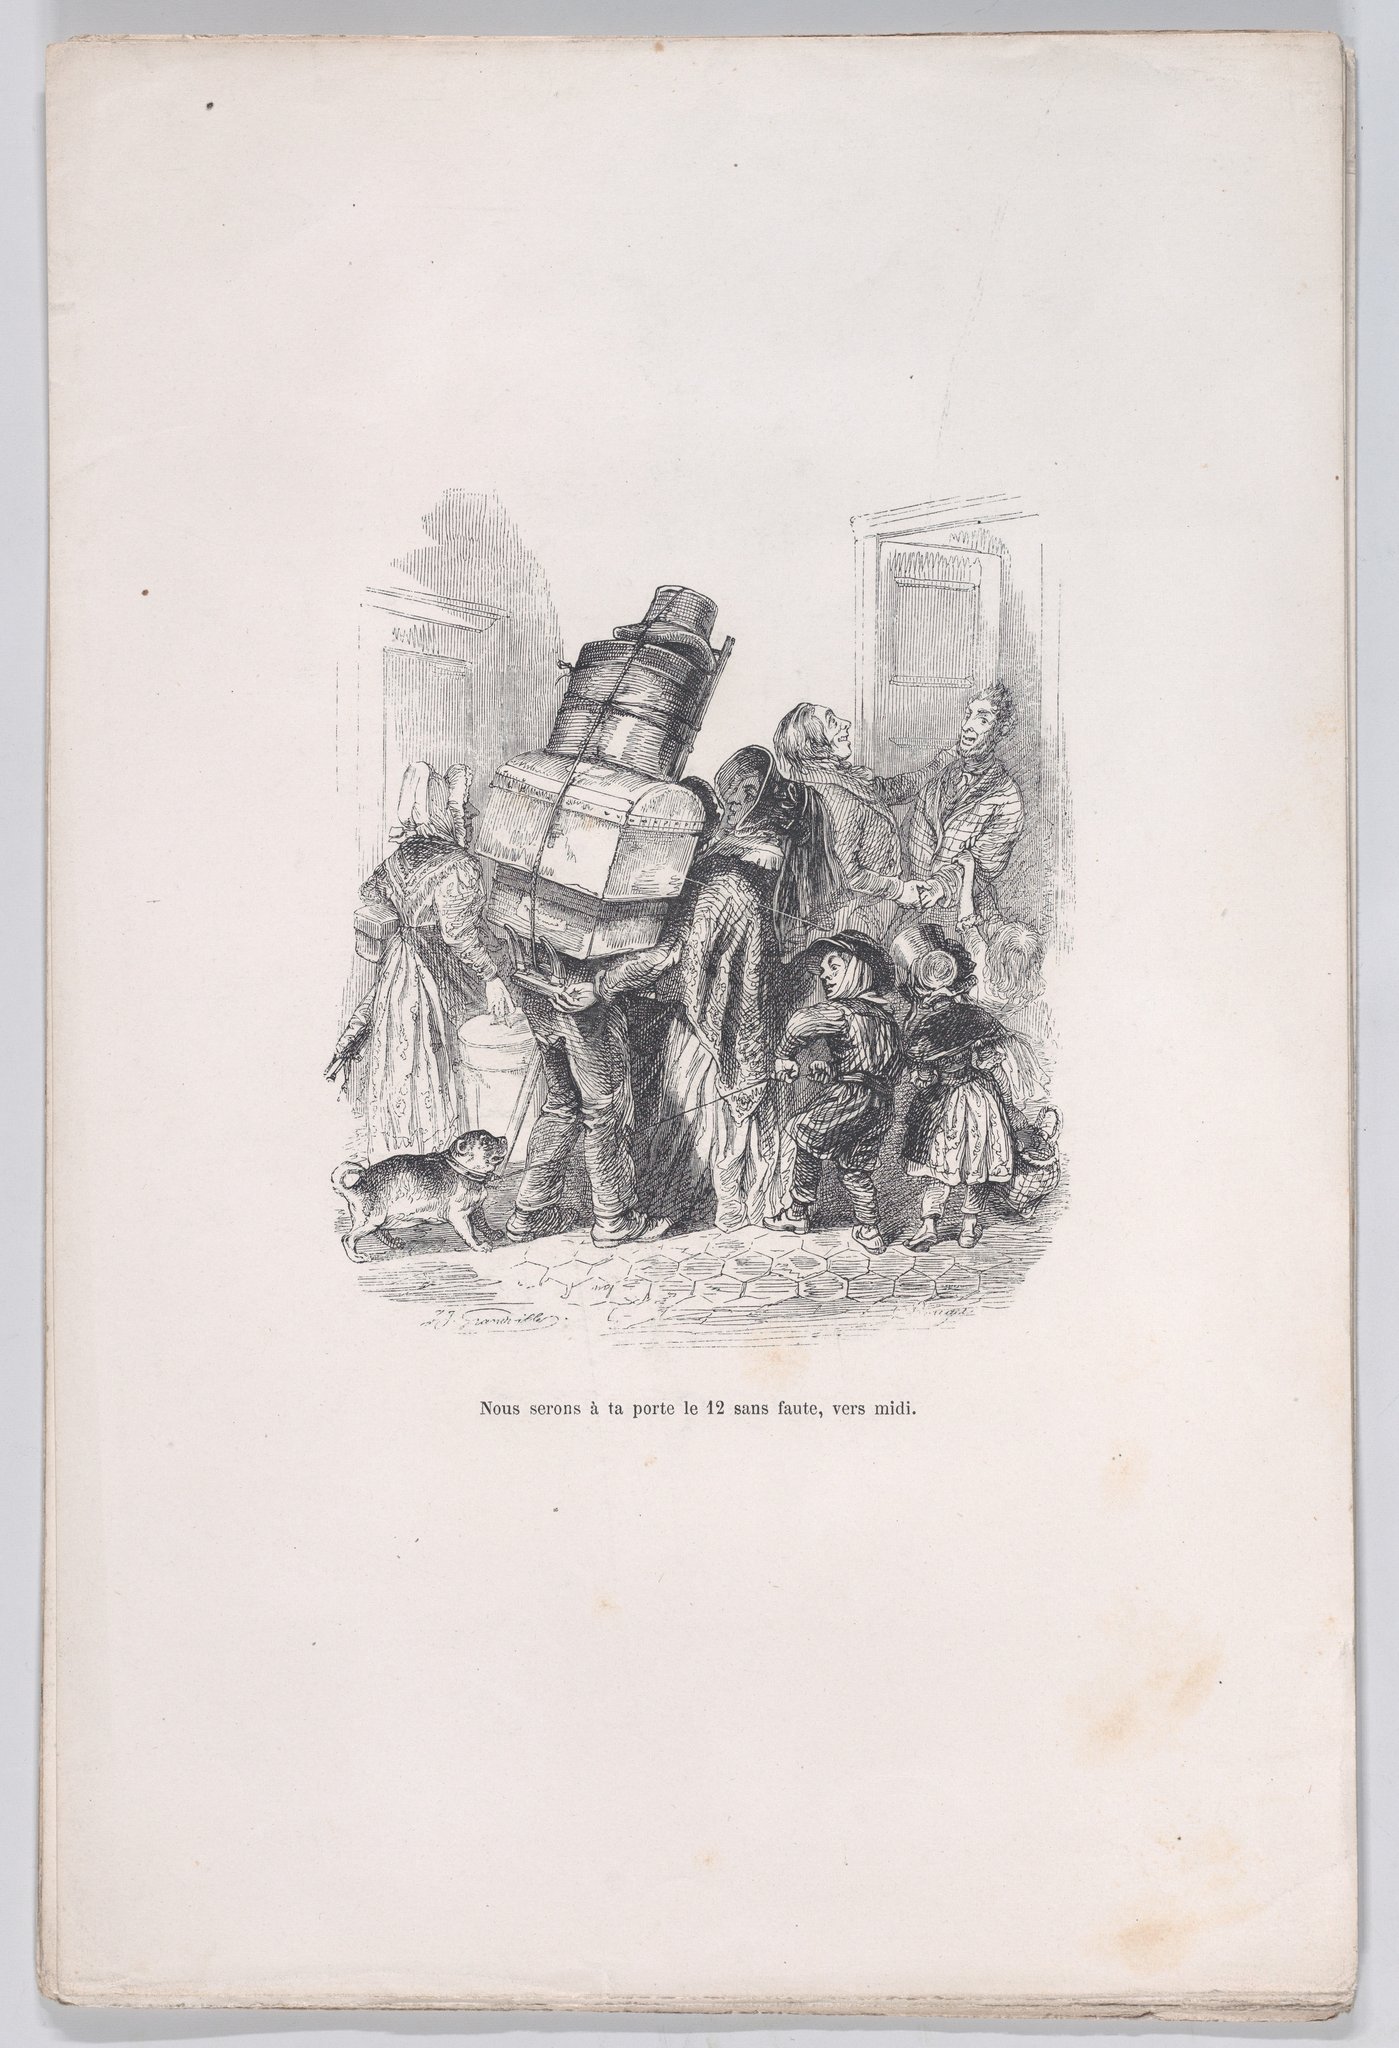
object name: print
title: We will be at your door at noon without fail, from "Little Miseries of Human Life"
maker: j. j. grandville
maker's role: illustrator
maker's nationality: french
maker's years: 1803-1847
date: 1843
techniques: engraving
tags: children,men,women,dogs